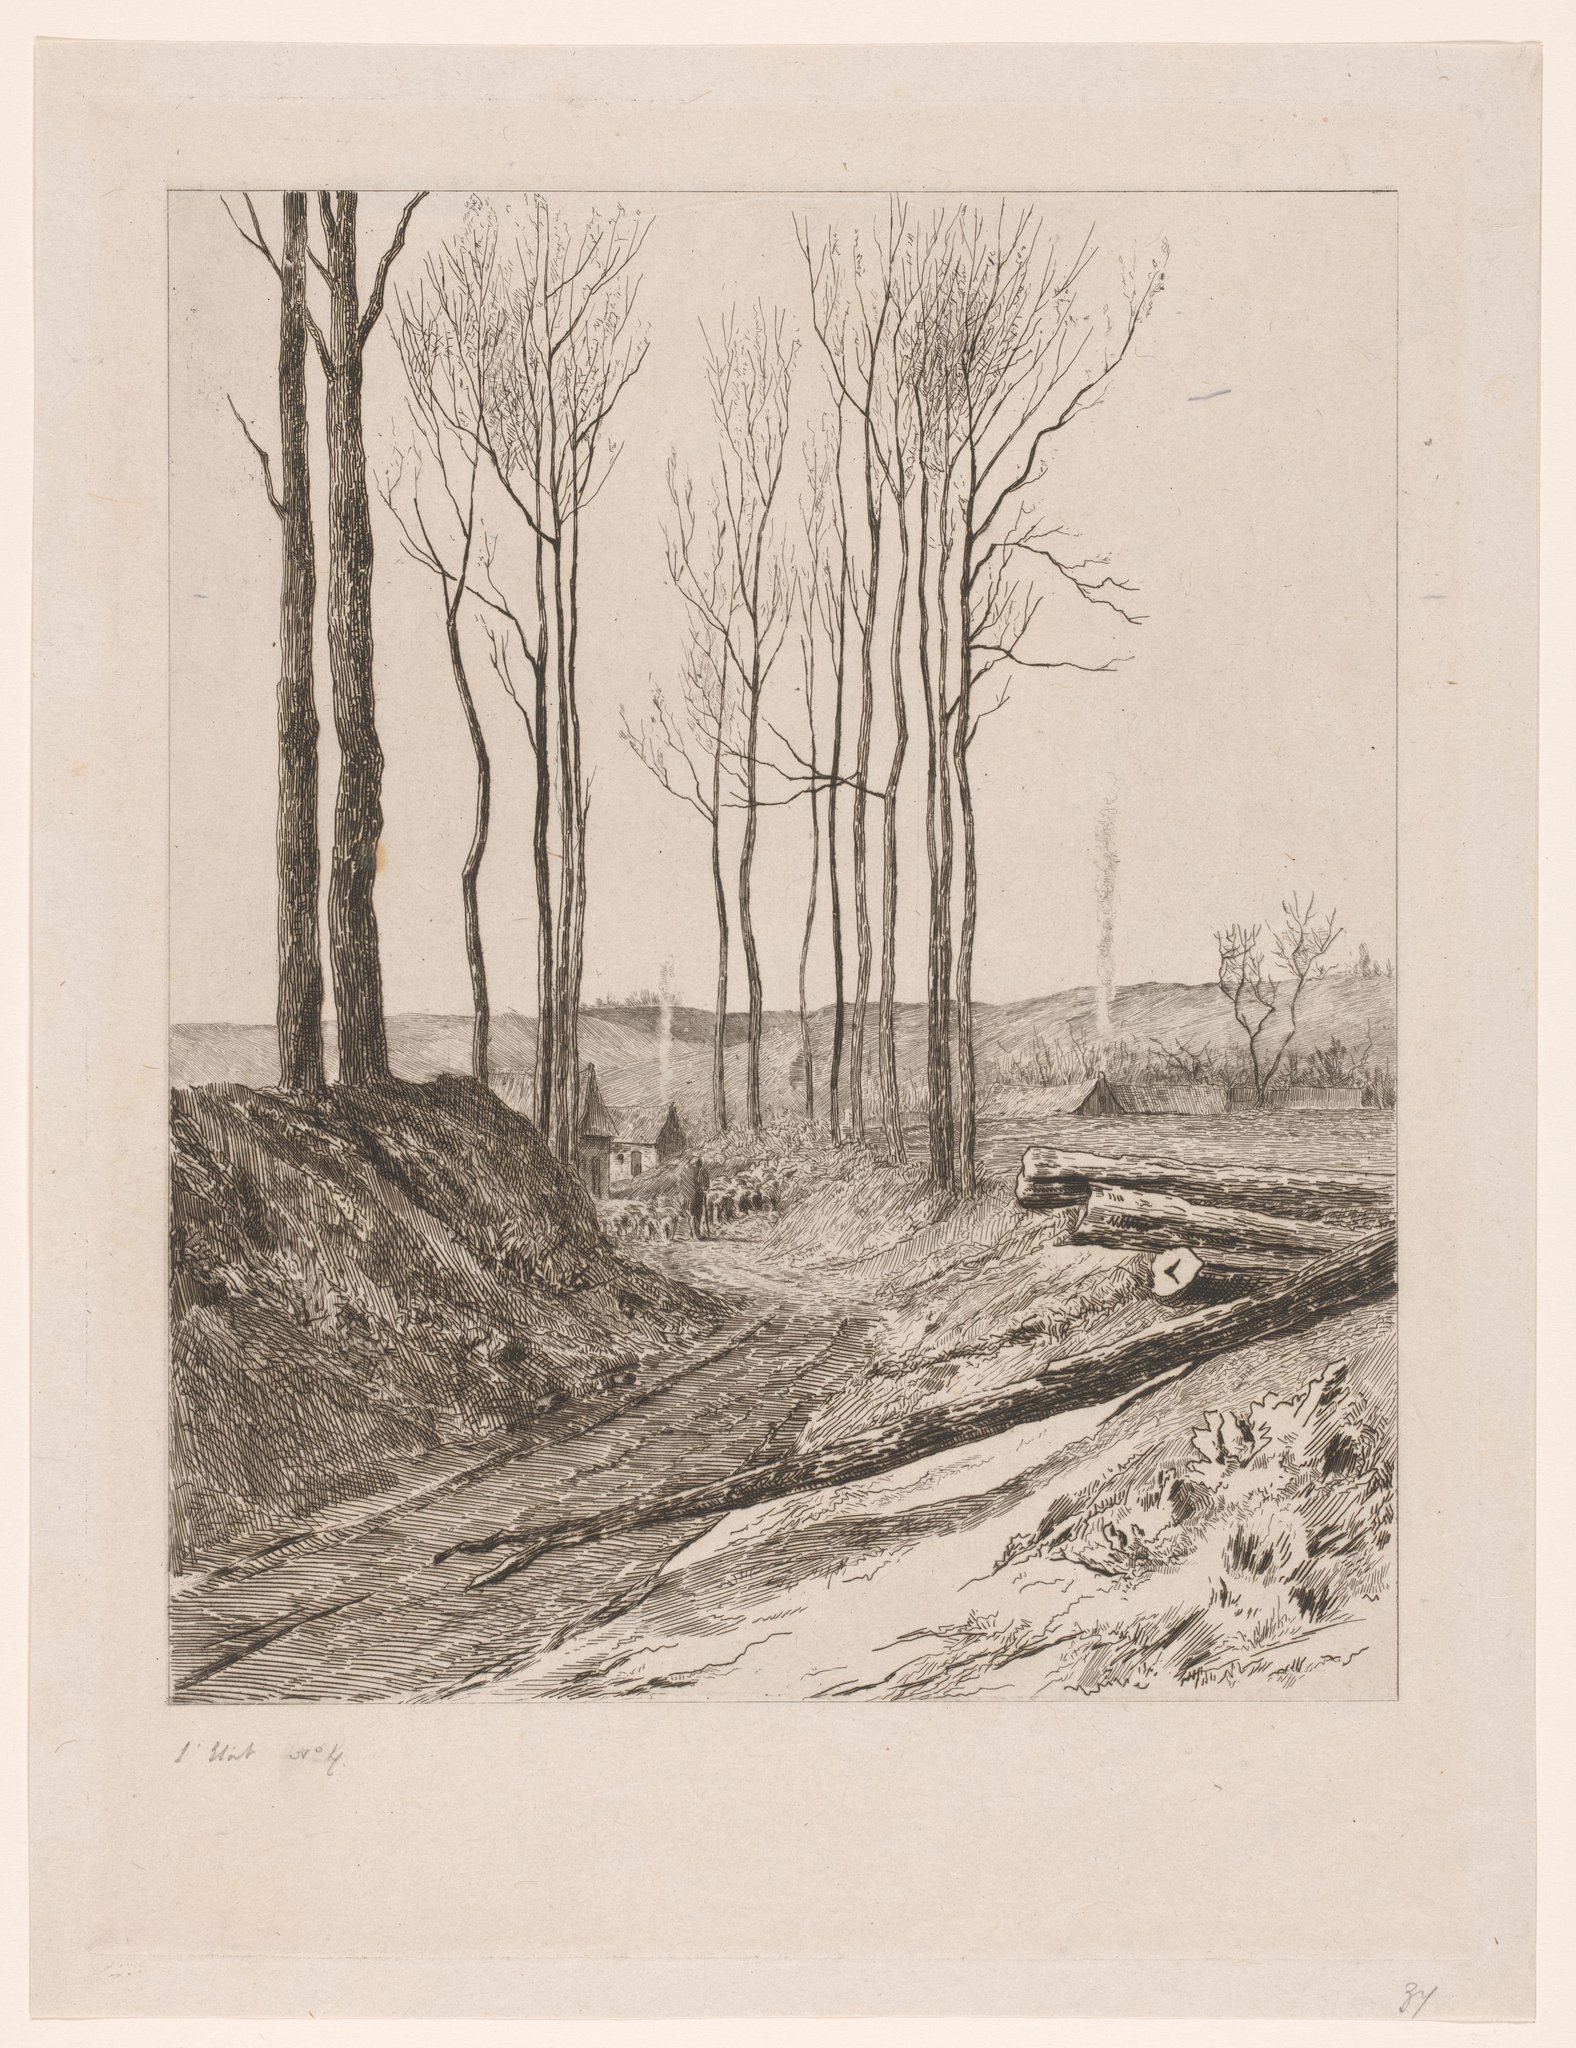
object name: print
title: Chemin près de Vilvorde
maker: carel nicolaas storm van s-gravesande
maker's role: draughtsman, print maker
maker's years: 1841-1924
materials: paper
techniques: etching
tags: road, path, herd, flock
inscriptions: collector's mark: Lugt 2228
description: Op de voorgrond liggen boomstammen aan de kant van de weg. Op de achtergrond loopt een herder met een kudde schapen.